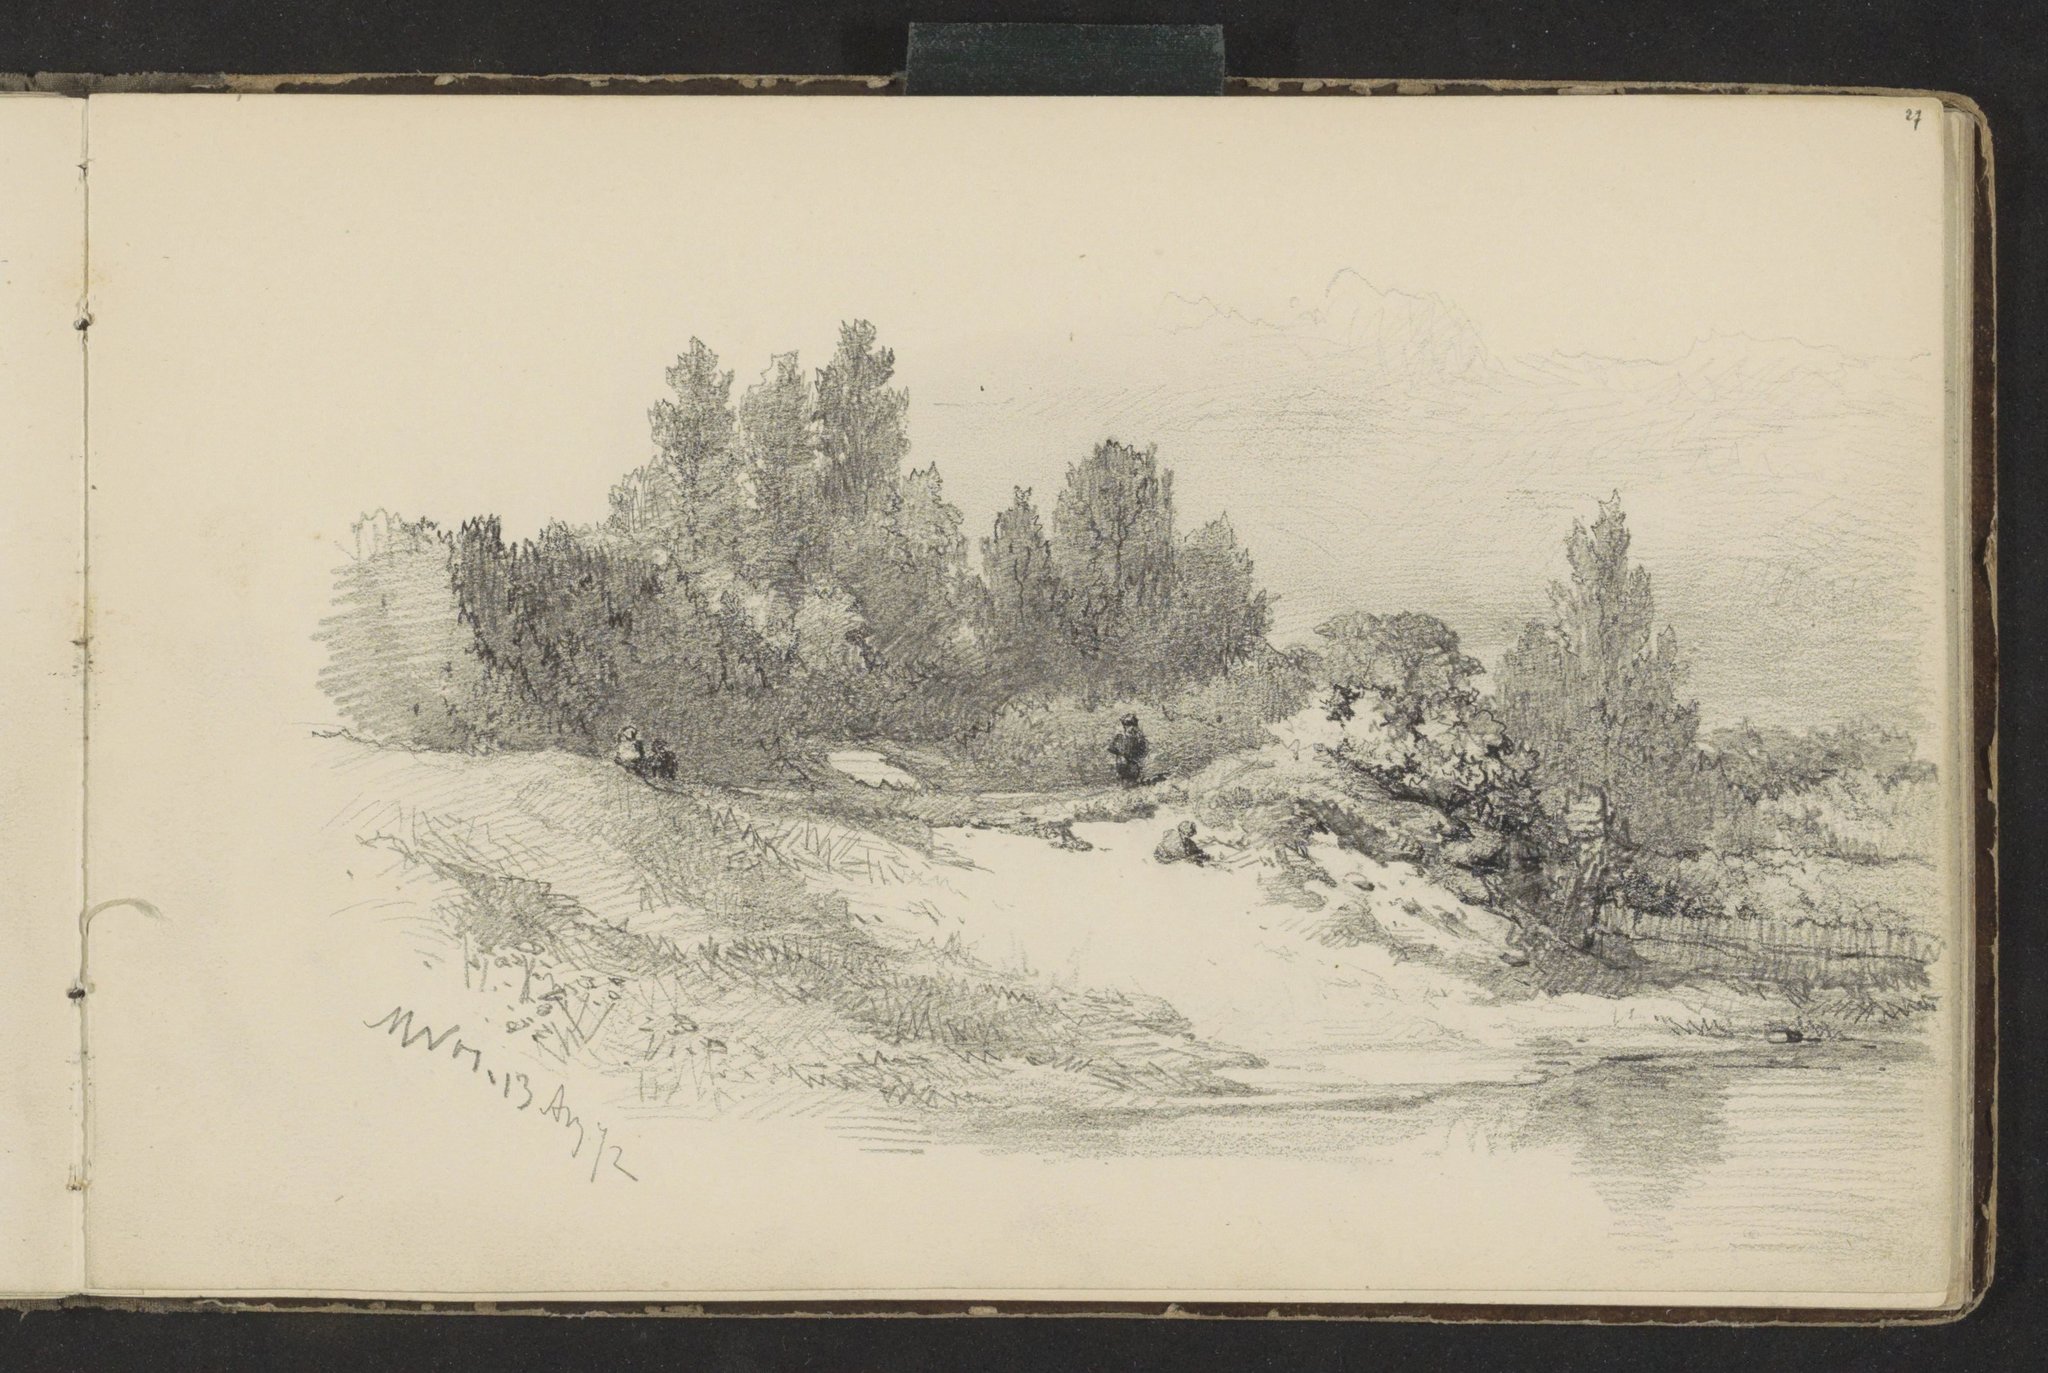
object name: sketchbook leaf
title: Figuren op een heuvel aan een waterkant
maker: maria vos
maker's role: draughtsman, painter, print maker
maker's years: 1824-1906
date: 1808-1872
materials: paper, pencil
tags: landscapes with waters, waterscapes, seascapes (in the temperate zone) (+ landscape with figures, staffage)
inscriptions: signature and date: ‘MV[...]. 13 Aug 72’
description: Blad 27 recto uit een schetsboek met 45 bladen.